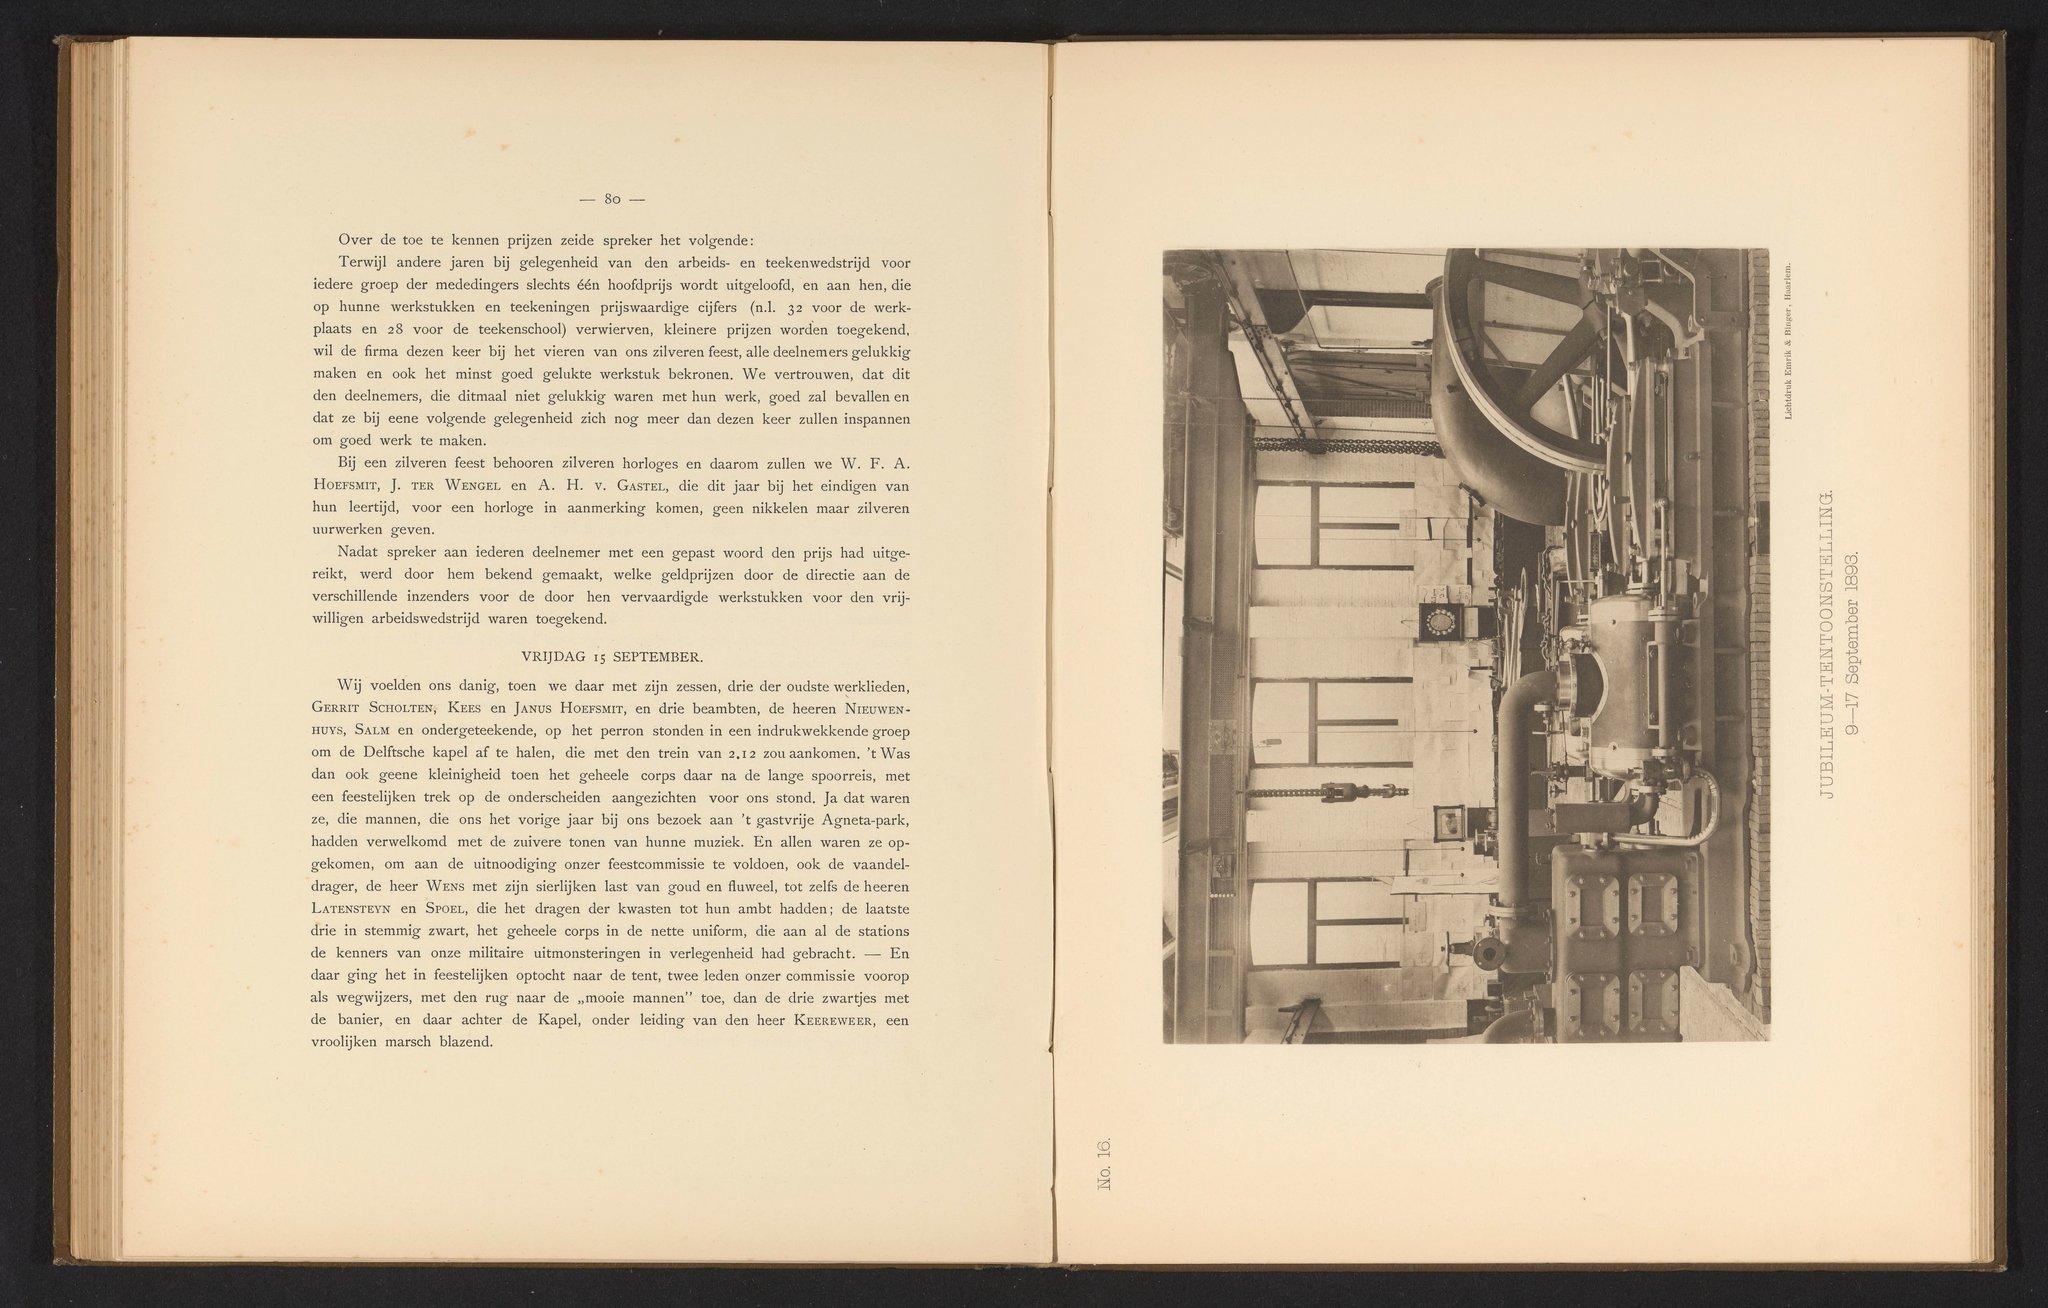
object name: photomechanical print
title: Jubileumtentoonstelling met een stoomketel voor het 25-jarig bestaan van de machinefabriek van Gebroeders Stork & Co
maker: Anonymous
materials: paper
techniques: photograph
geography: haarlem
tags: factory-interior, machine shop, collection, exhibition, show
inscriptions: number: ‘No. 16.’